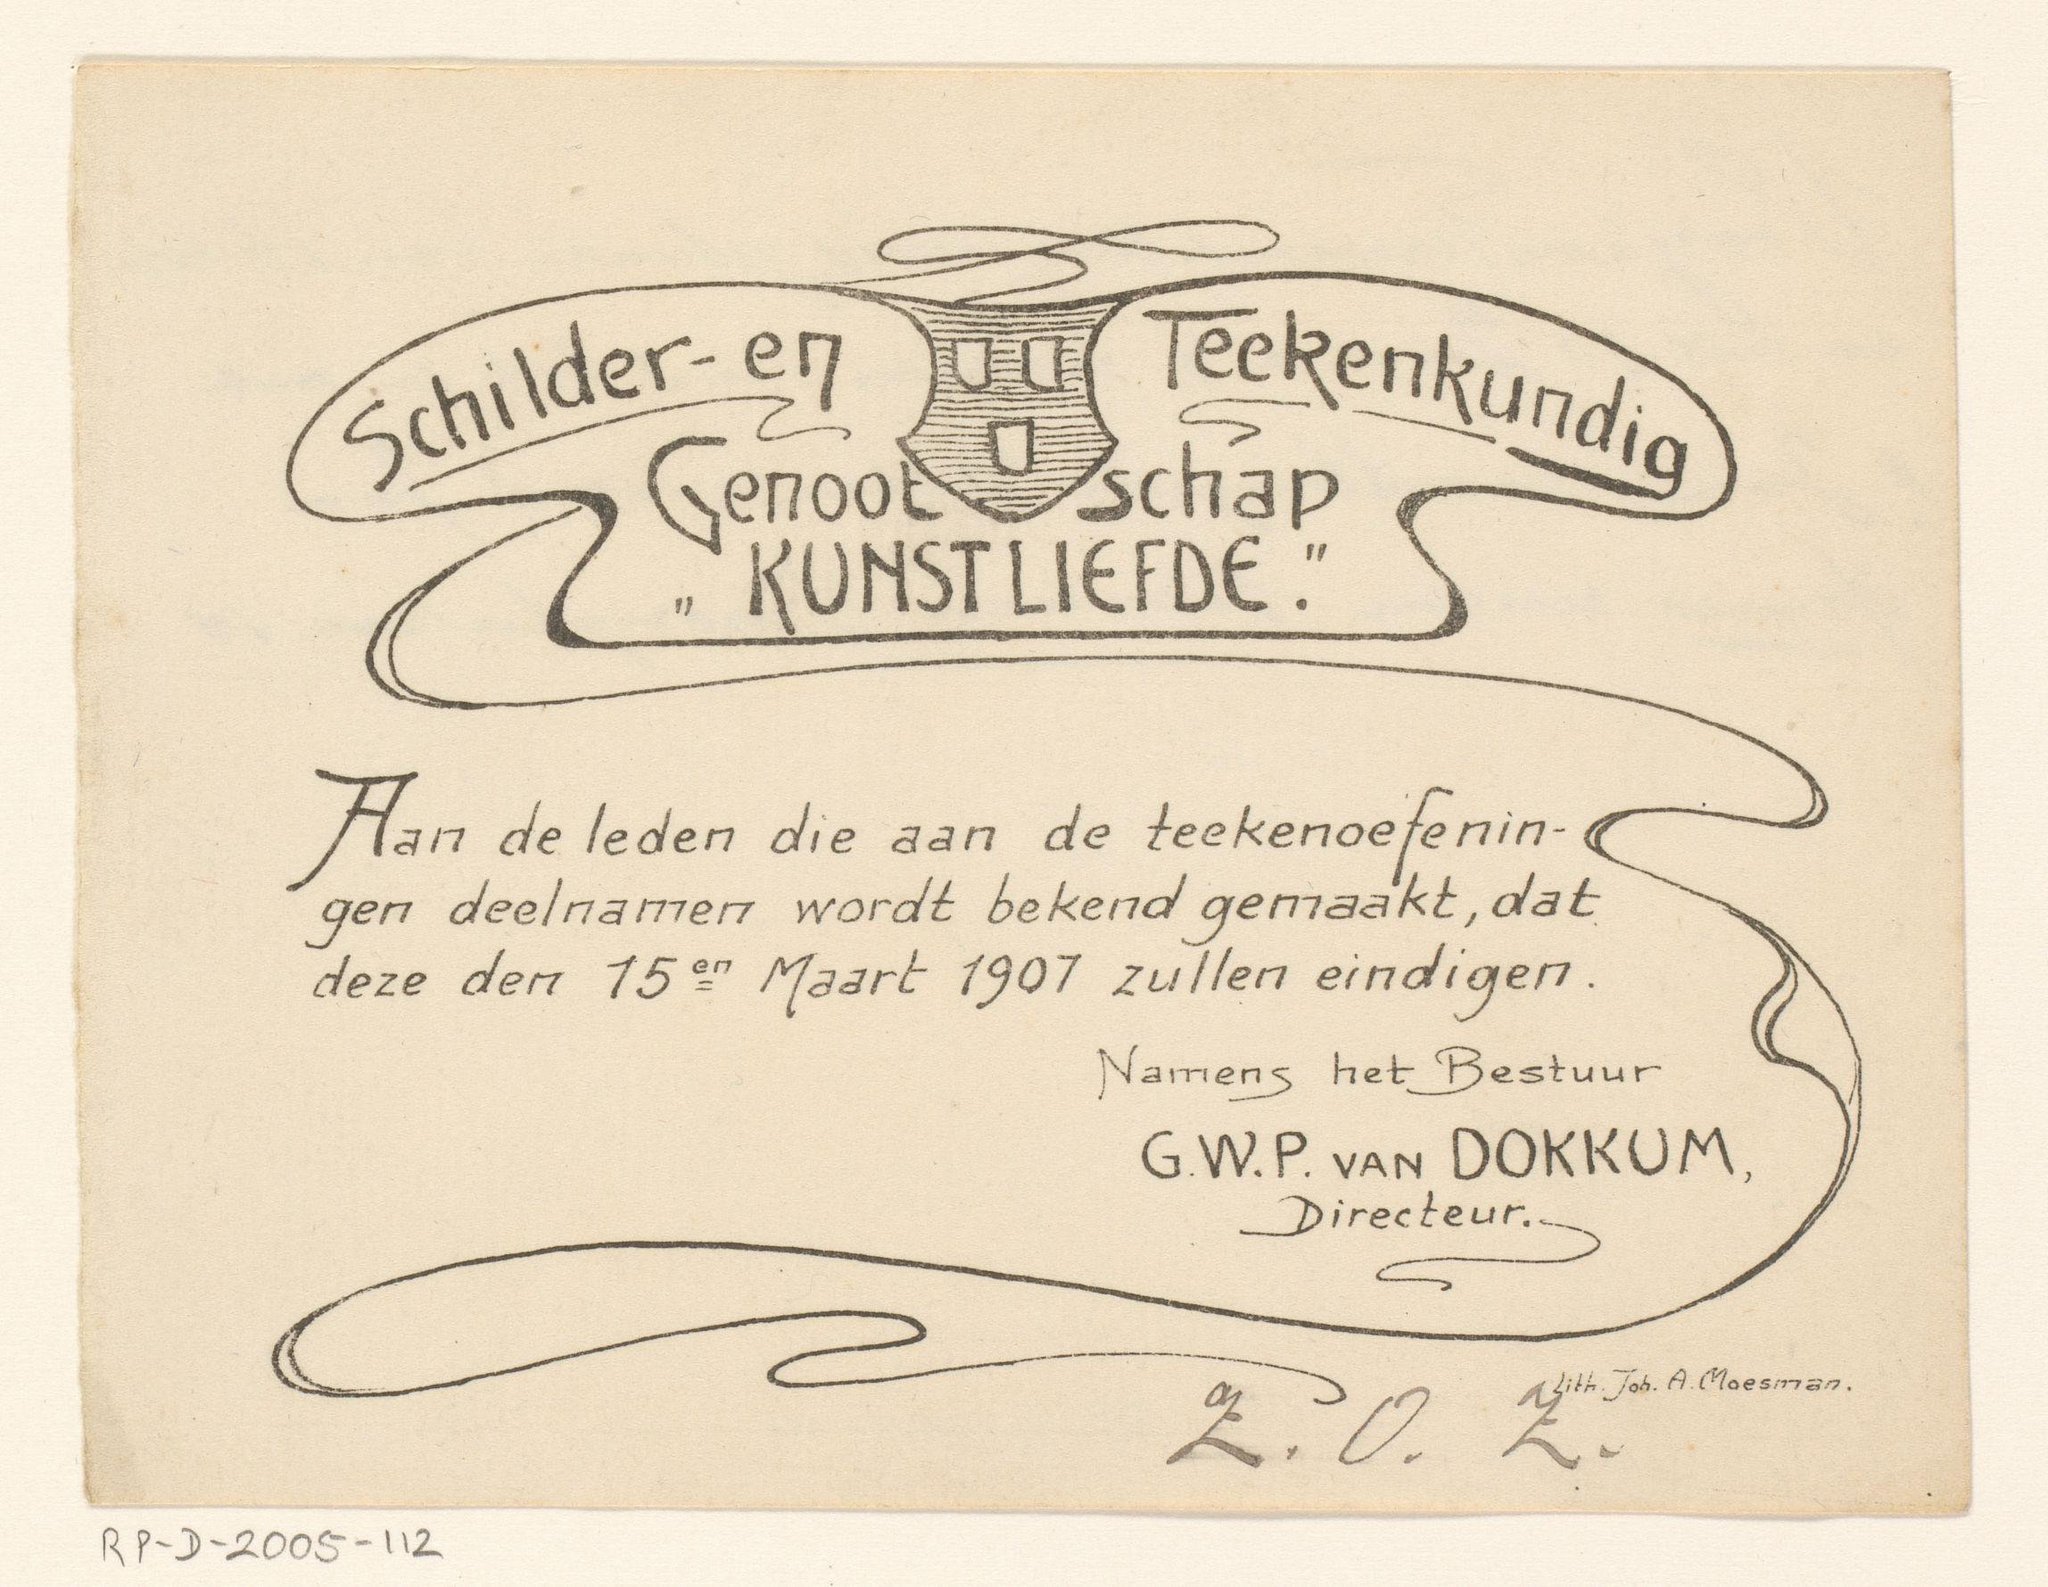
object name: print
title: Kennisgeving door Schilder- en Teekenkundig Genootschap "Kunstliefde", 1907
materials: paper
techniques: lithograph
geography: netherlands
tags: criticizing and discussing art, art criticism, circle, club of artists, collecting and exhibiting products of the fine arts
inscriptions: collector's mark: Lugt 2228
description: Kennisgeving van Schilder- en Teekenkundig Genootschap "Kunstliefde" dat de tekenoefeningen zullen eindigen op 15 maart 1907. Op de achterzijde nog een handgeschreven notitie.